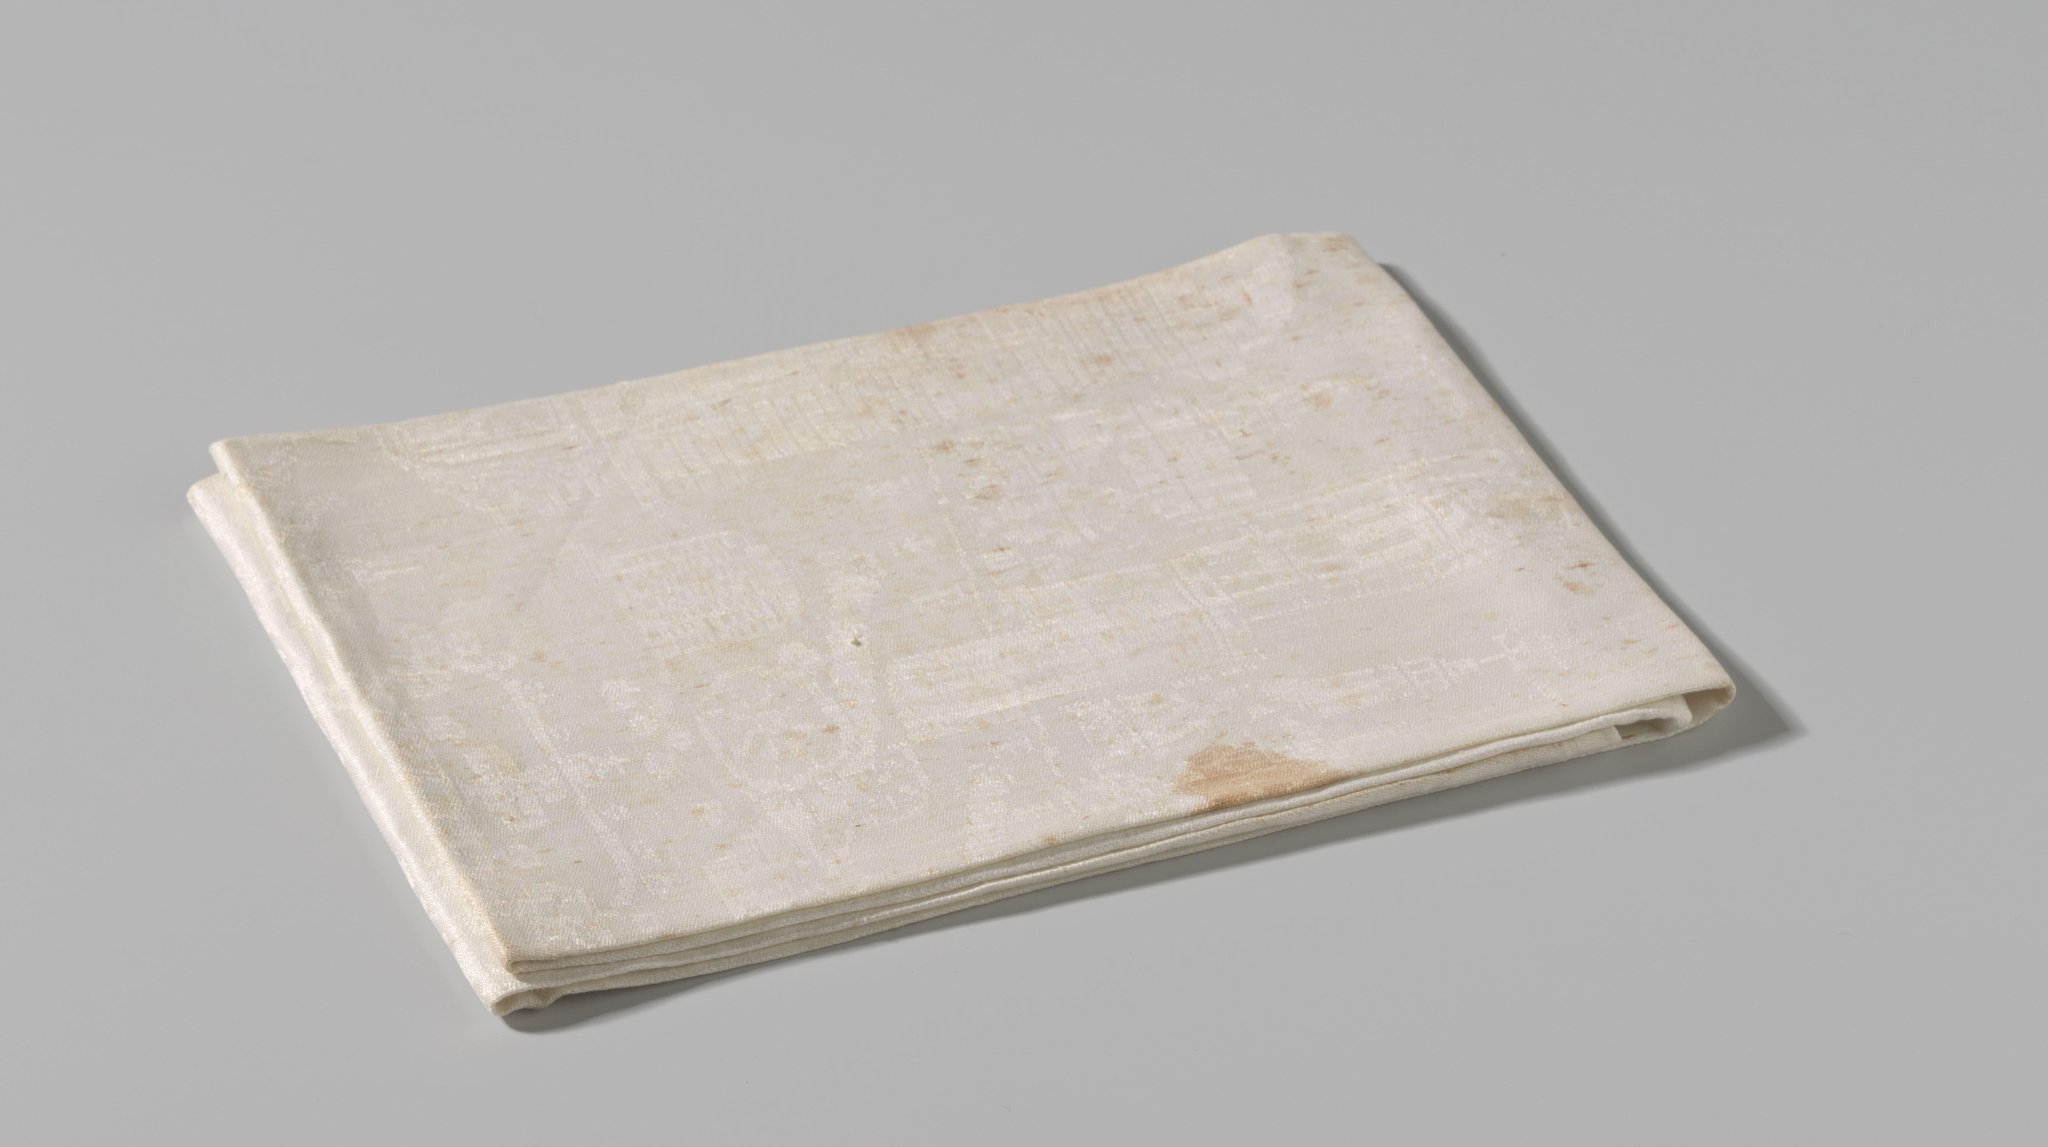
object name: napkin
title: Servet van linnendamast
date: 1702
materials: linen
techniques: damask, weave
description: Servet van linnendamast, herovering van Landau door de geallieerden in de Spaanse Successieoorlog. Vertoont van onder naar boven de wapens van het Heilige Roomse Rijk, Holland en Engeland, een stadsgezicht op de belegerde vesting Landau (inweving: LANDAVW), het wapen van Oostenrijk, een door een engel belauwerde veldheer te paard en een gekroonde dubbele adelaar, het geheel binnen een brede band van wapentrofeeën; onder de stadspoort van Landau wordt het wapen van Kortrijk afgebeeld.